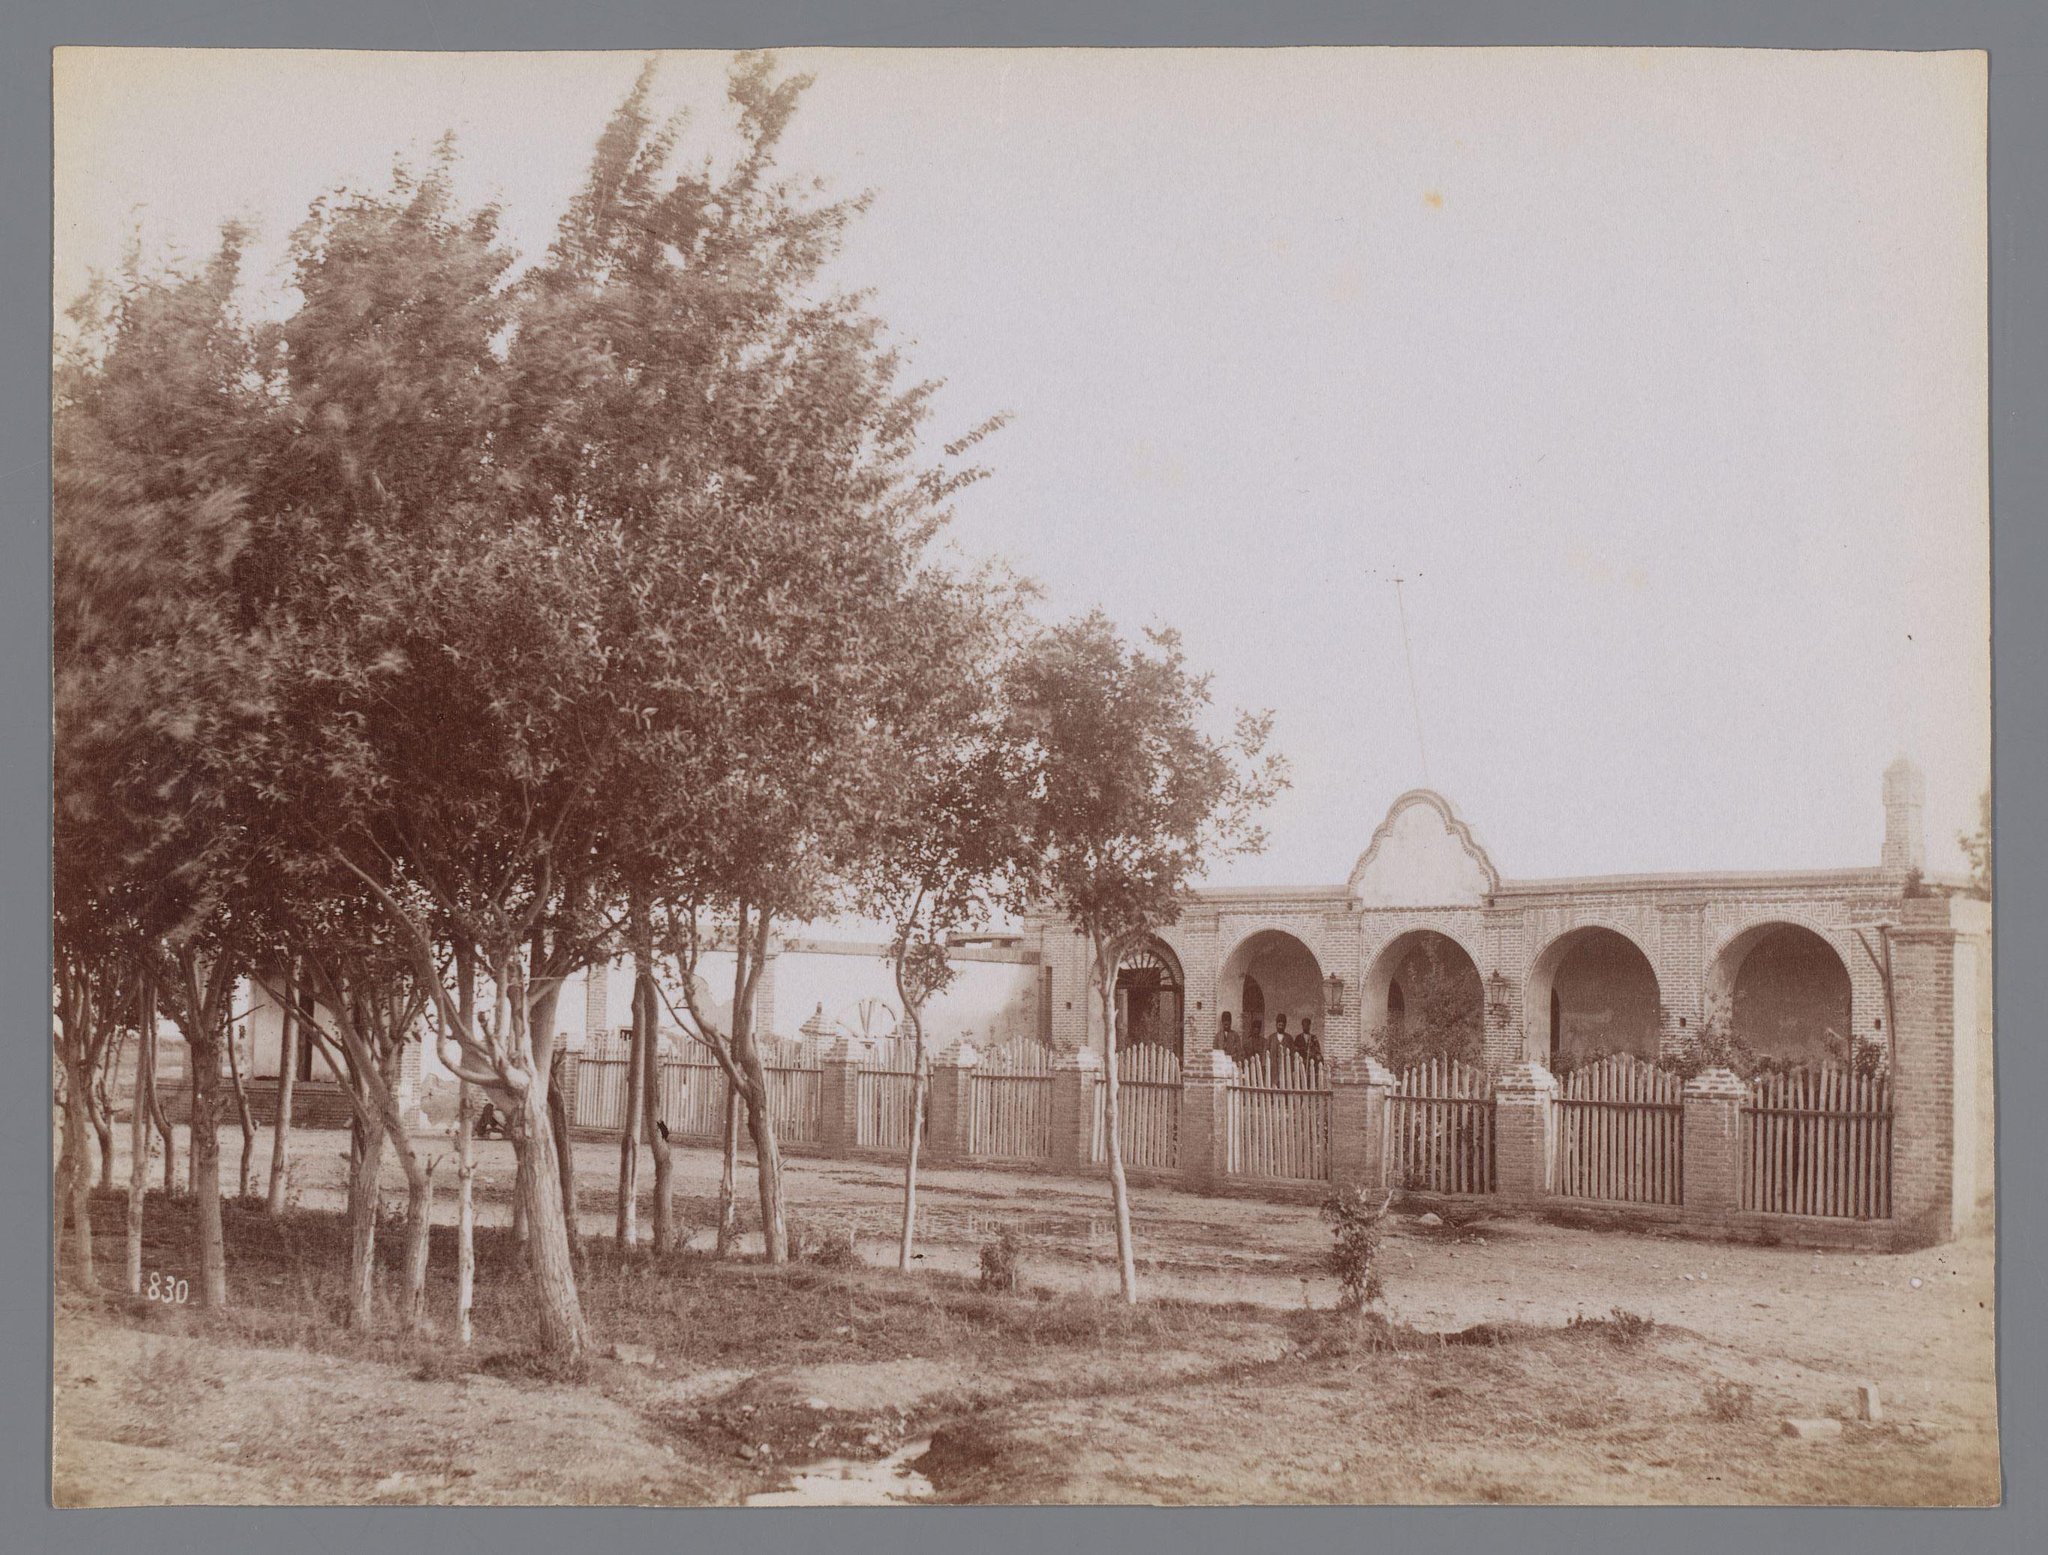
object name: photograph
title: Landschap en gebouw [moskee?], "La route de Rescht", Iran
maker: antoine sevruguin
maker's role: fotograaf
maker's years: 1840-1933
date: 1885-1910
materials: paper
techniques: albumen print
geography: iran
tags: iran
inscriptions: number: ‘29’, number: ‘830’, inscription: ‘La route de Rescht//Chahabail [?]’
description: Landschap en gebouw [moskee?], "La route de Rescht", Iran.